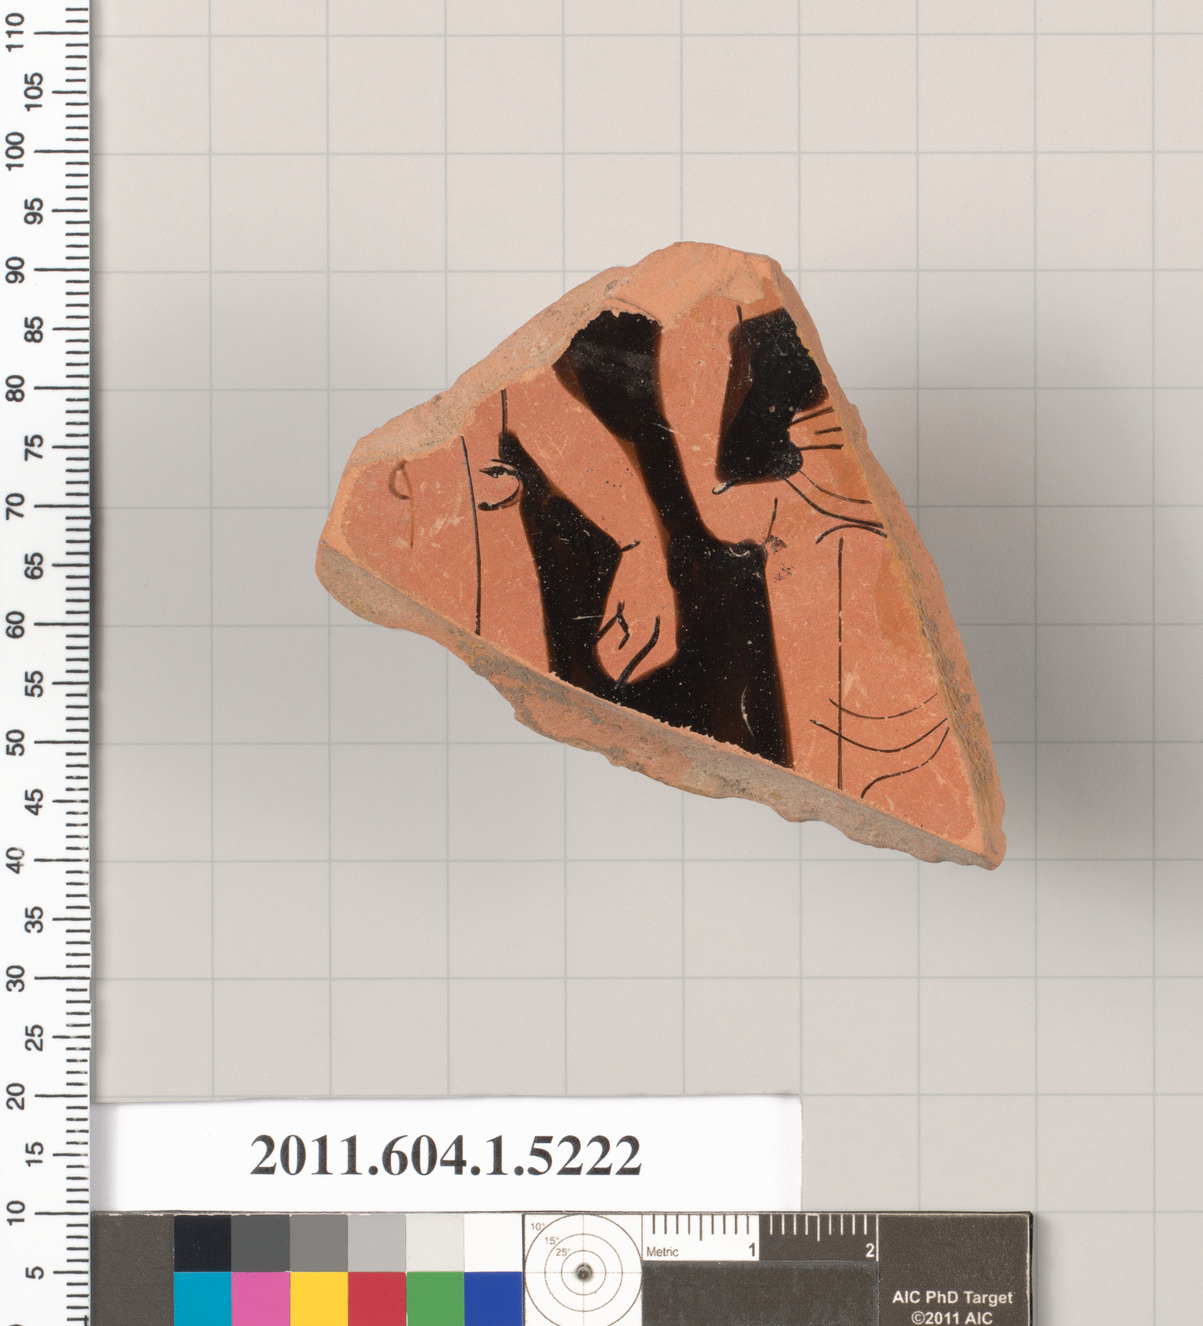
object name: kylix fragment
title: Terracotta fragment of a kylix (drinking cup)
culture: greek, attic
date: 467-435 BCE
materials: terracotta